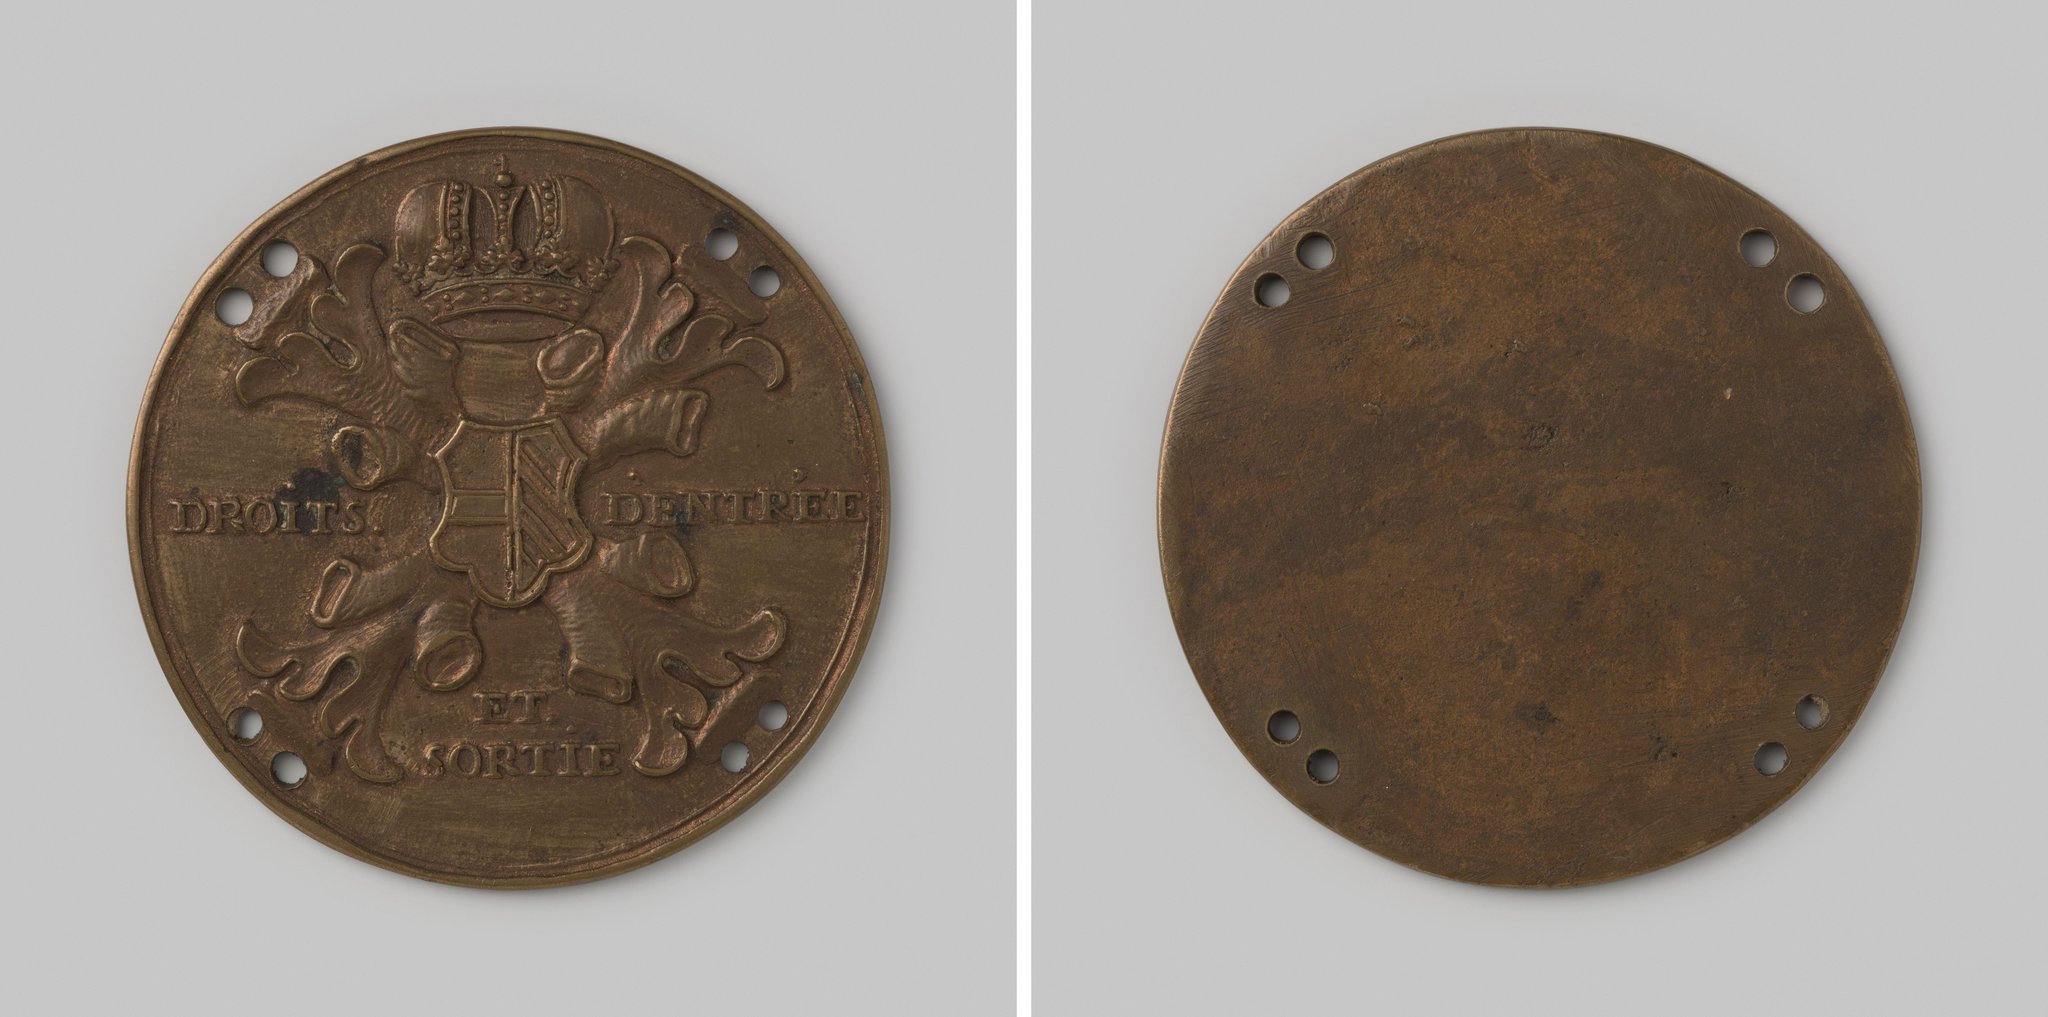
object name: history medal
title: Schild van de dienst van In- en Uitgaande Rechten in de Oostenrijkse Nederlanden, 18e eeuw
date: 1713-1794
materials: brass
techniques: casting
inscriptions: : ‘DROITS. - D'ENTRÉE / ET. / SORTIE’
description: Ronde messing plaat met bij de rand viermaal twee dunne doorboringen, afgebeeld een gekroond ingebogen Oostenrijks wapenschild op twee gekruiste stokken, met links rechts en onder tekst.